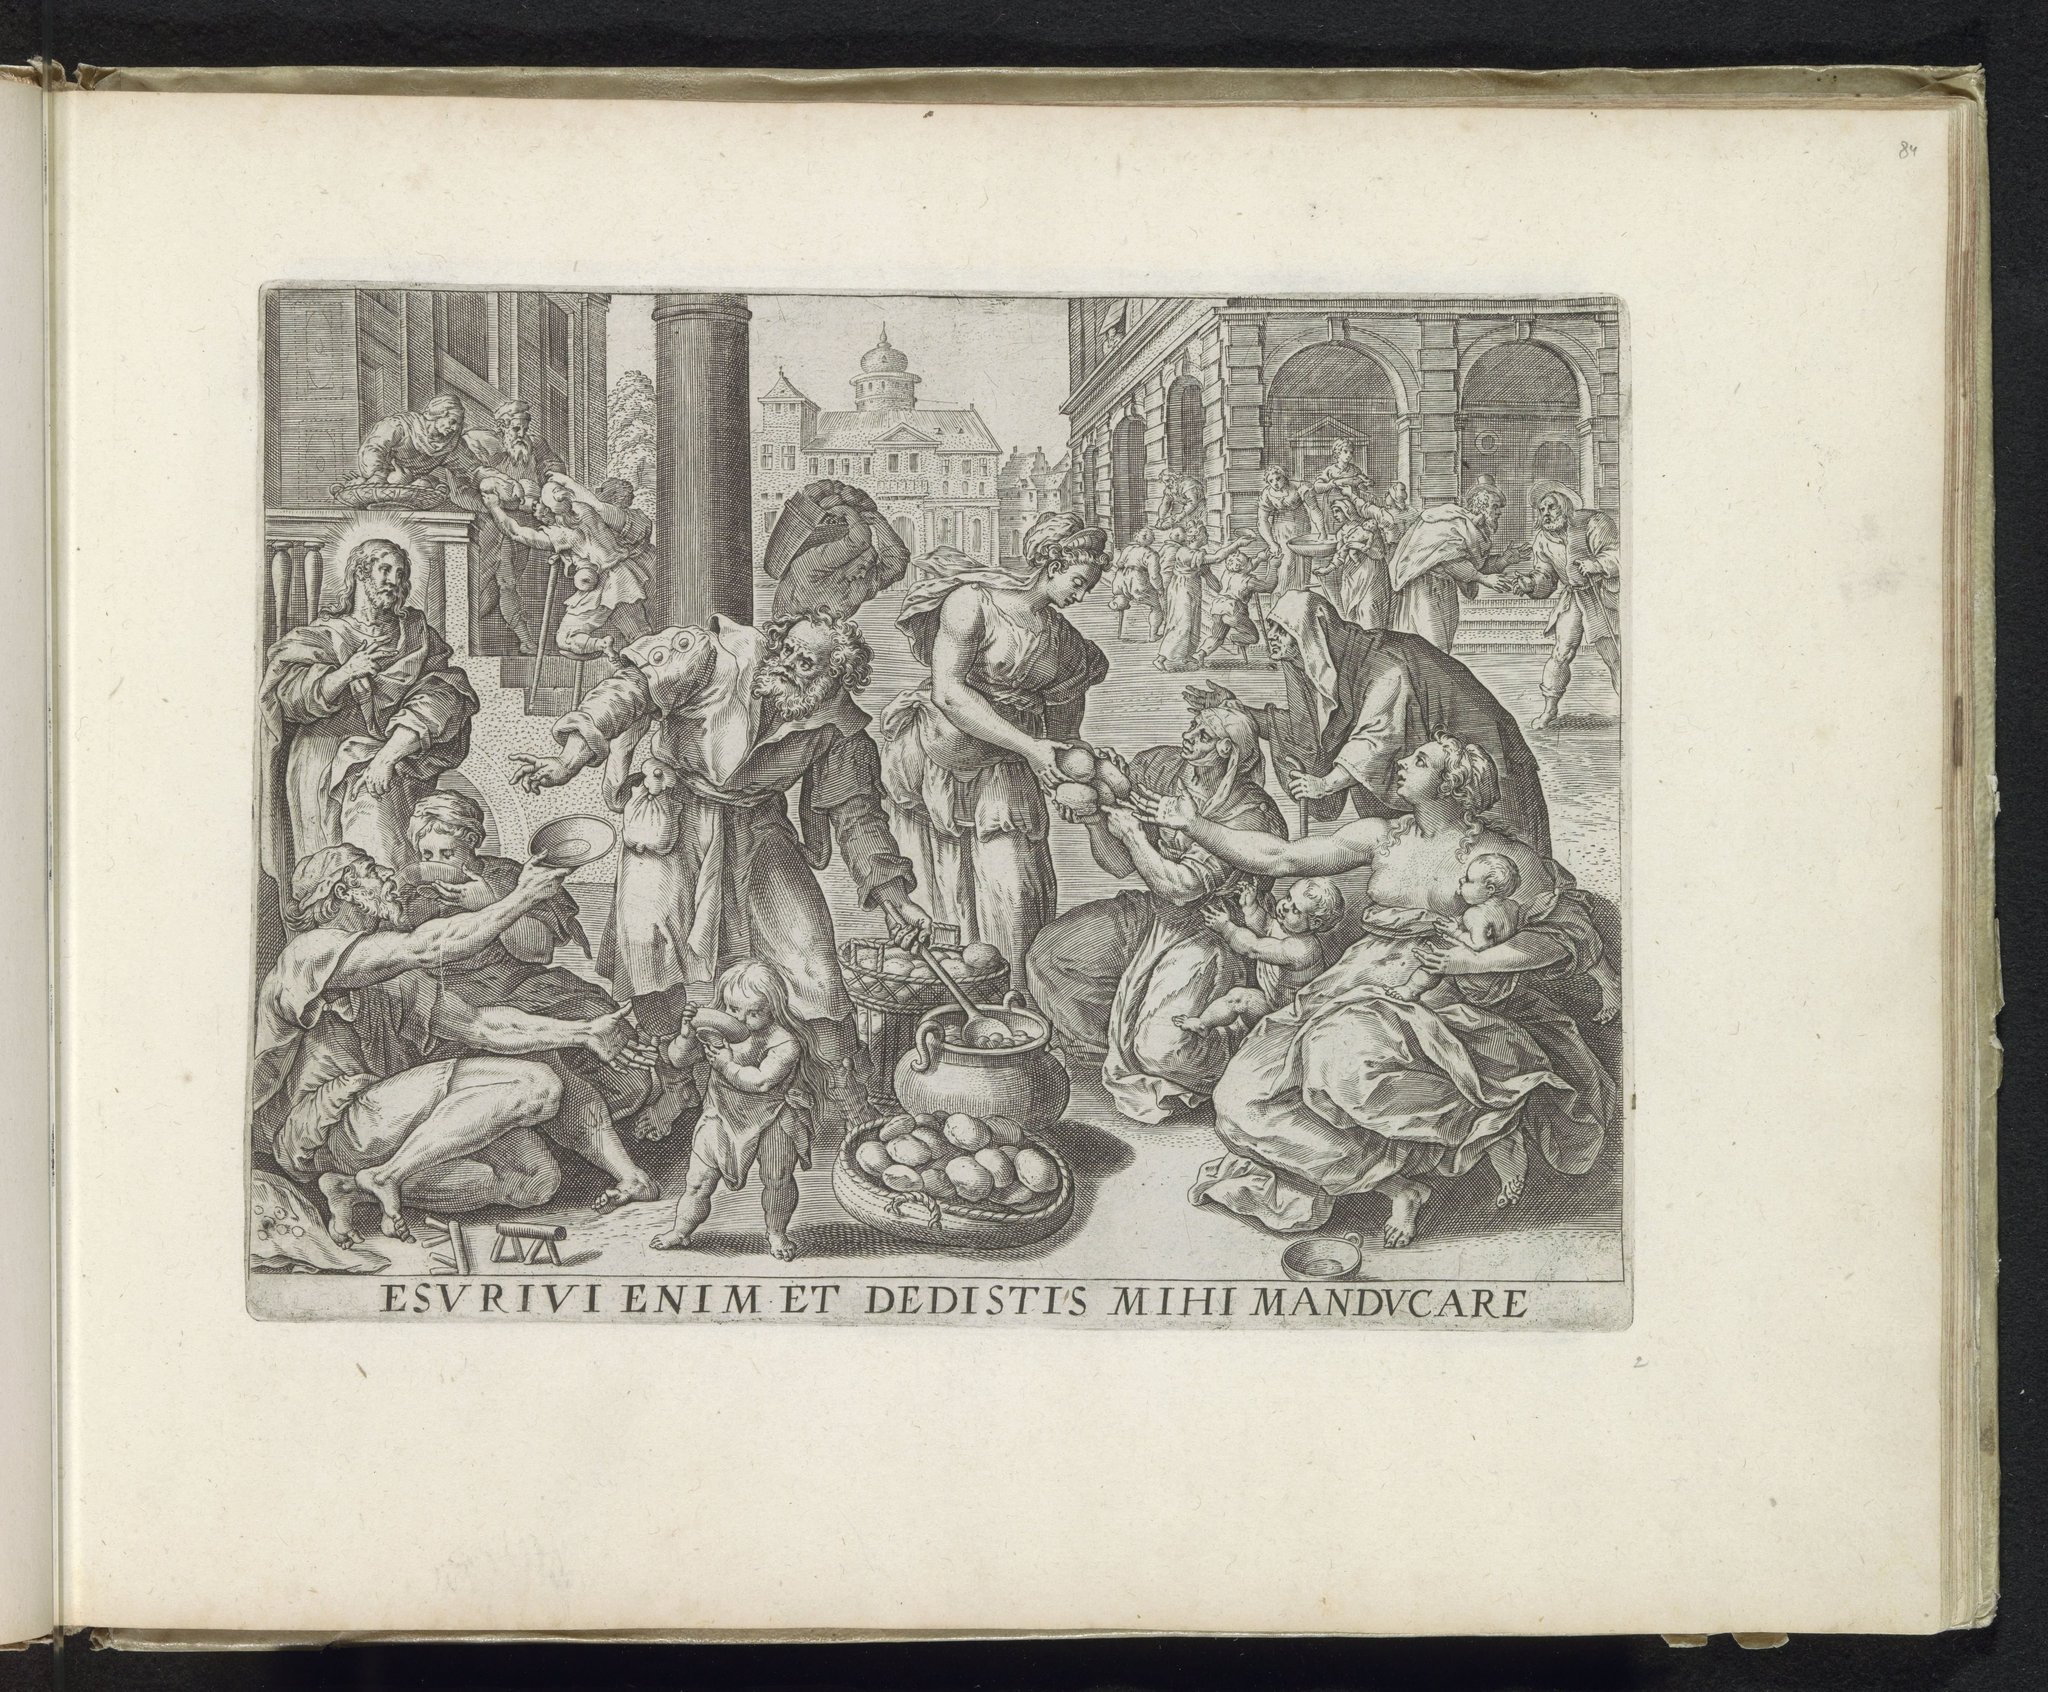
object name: album leaf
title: Zeven werken van barmhartigheid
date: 1585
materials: paper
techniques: engraving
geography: antwerp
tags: feeding the hungry, 'esuriens cibatur' ~ one of the (seven) acts of mercy - vv - christ present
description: Op de voorgrond delen een man en een vrouw voedsel uit aan de hongerigen. Links kijkt Christus toe. Op de achtergrond wordt eveneens voedsel uitgedeeld. Onder de voorstelling een verwijzing in het Latijn naar de Bijbeltekst. Deze prent maakt deel uit van een album.